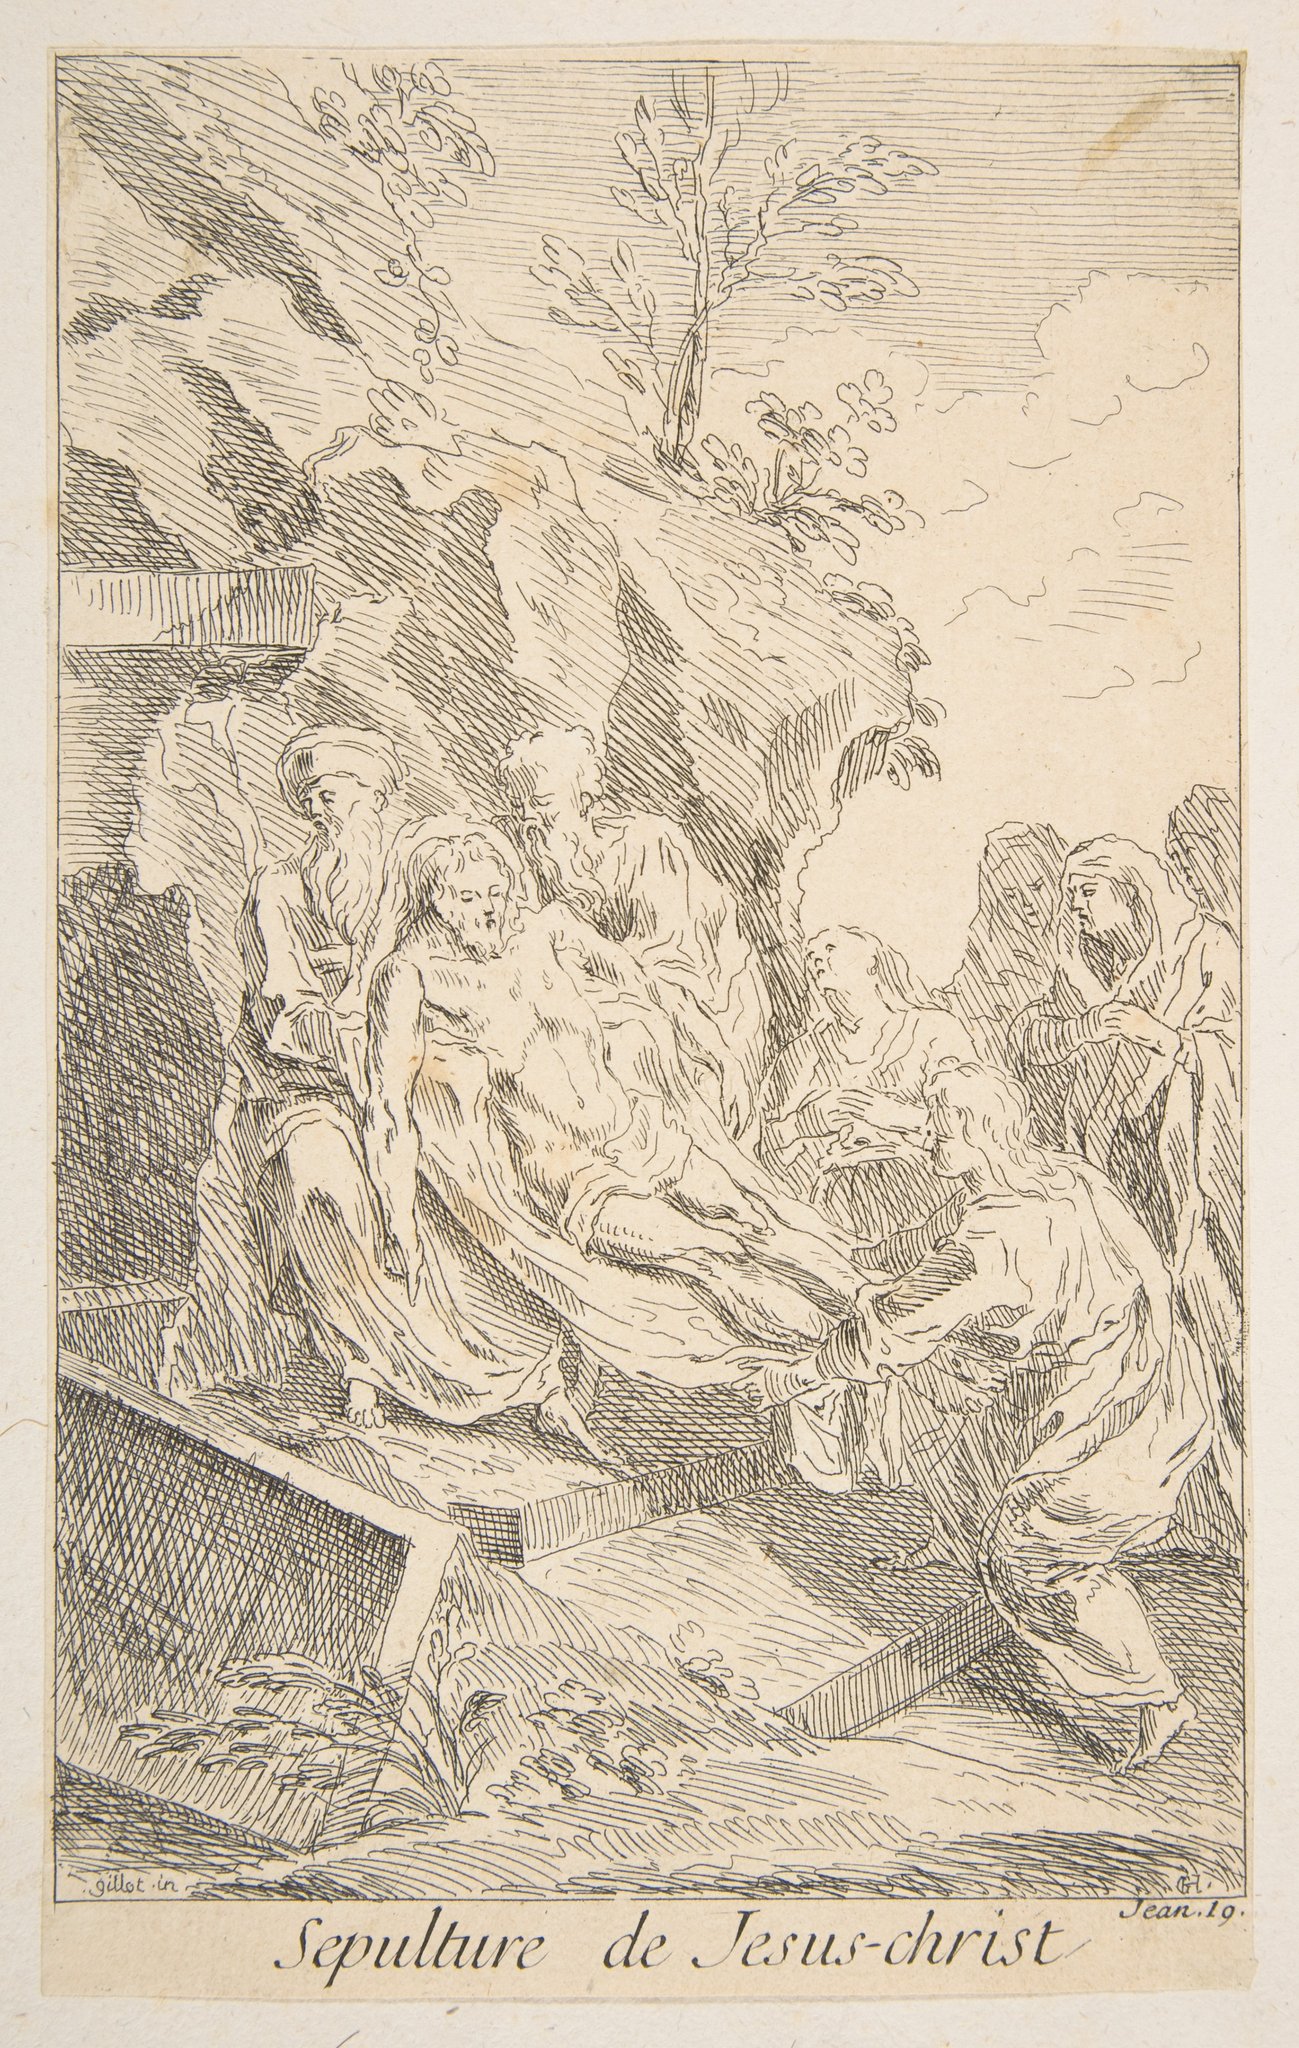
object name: print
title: Entombment of Christ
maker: claude gillot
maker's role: artist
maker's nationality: french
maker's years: 1673-1722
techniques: etching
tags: christ,entombment